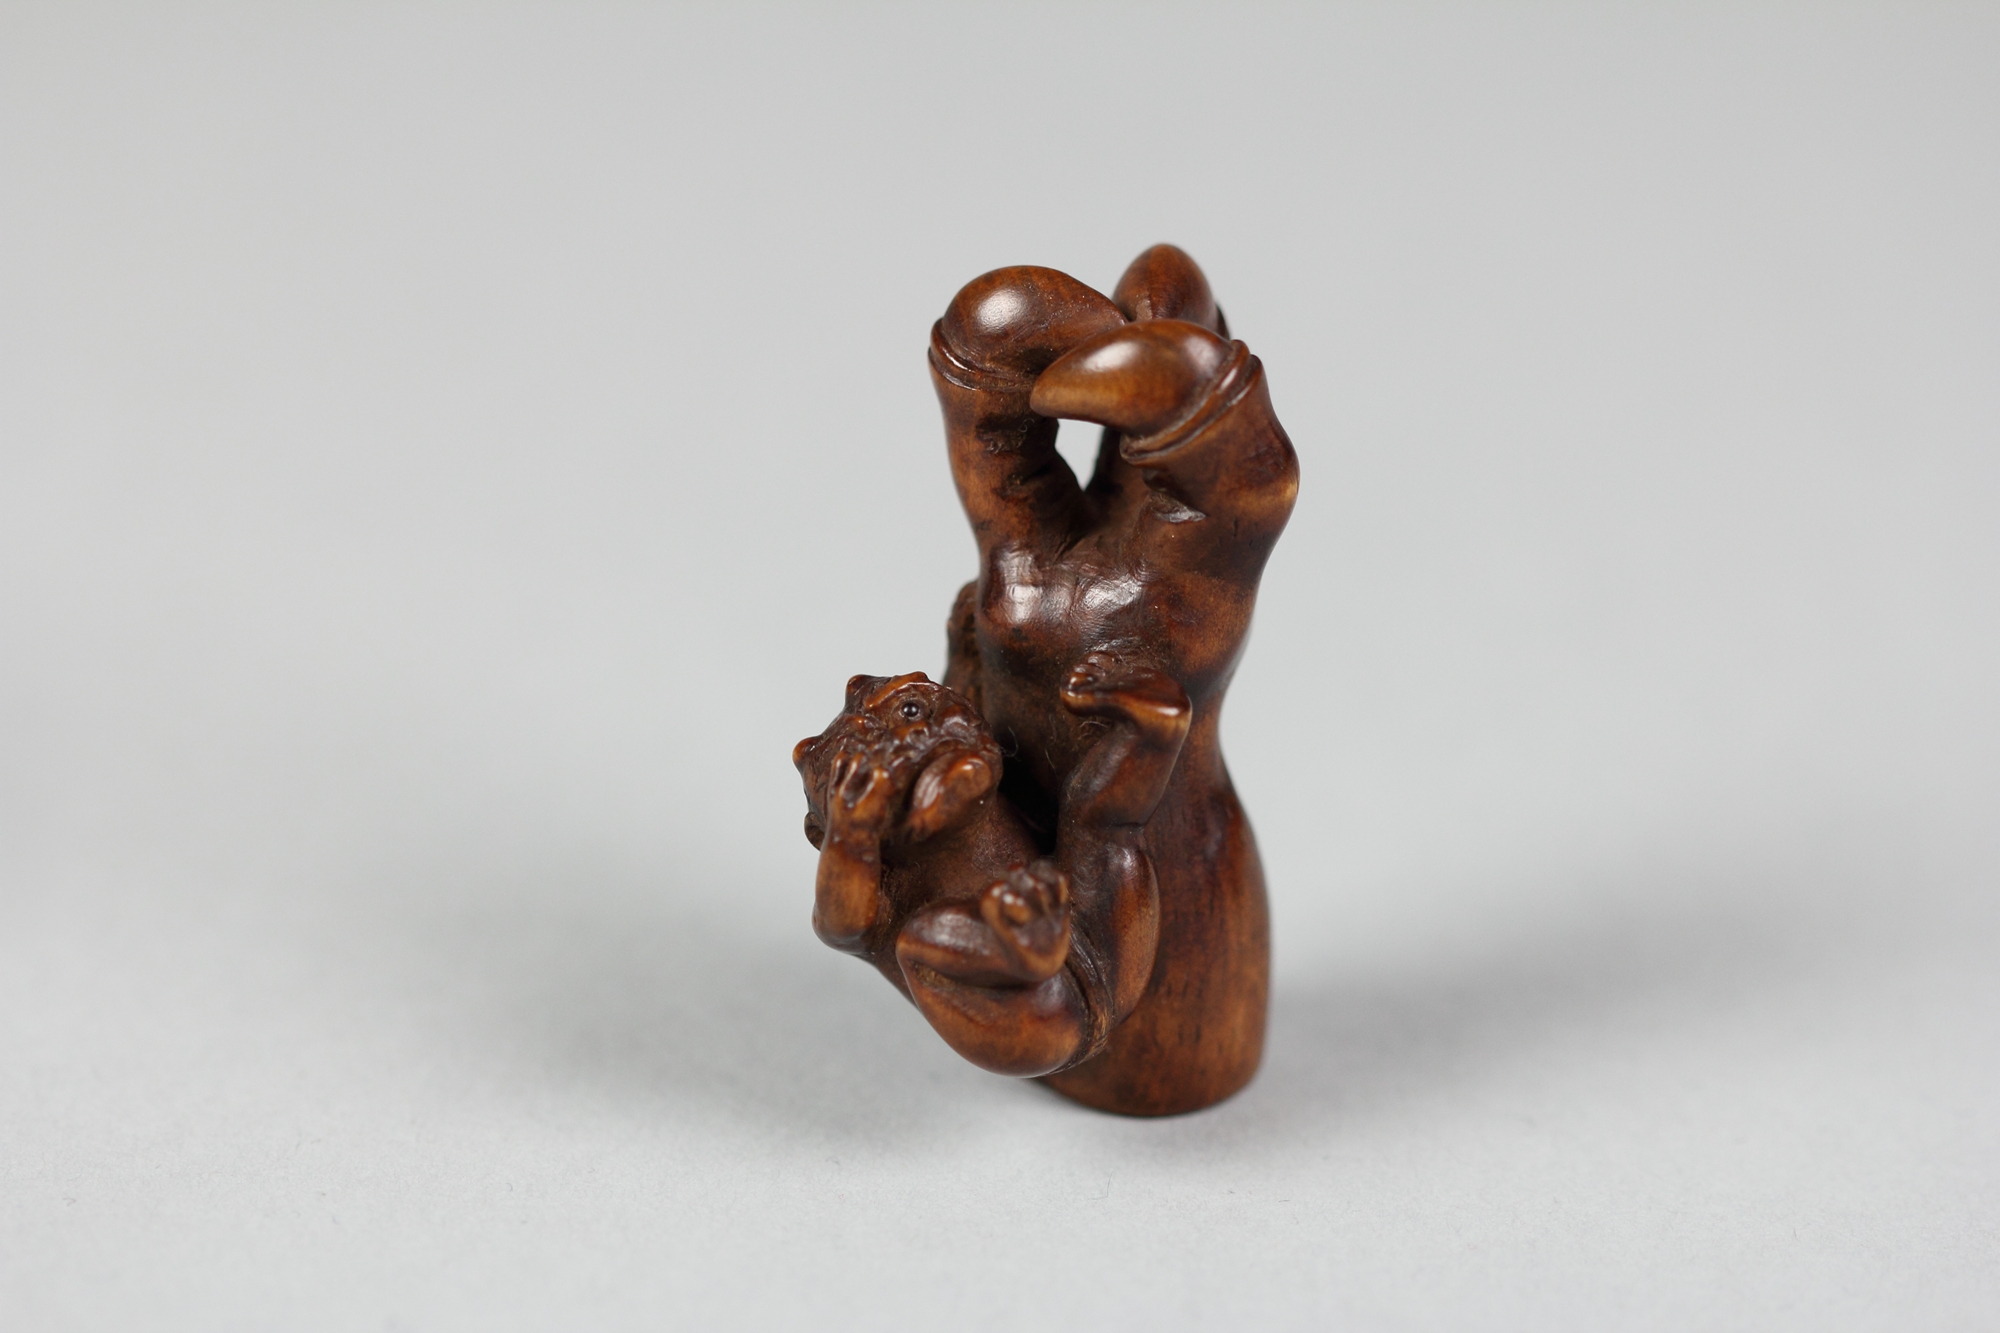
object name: netsuke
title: Netsuke of Ōni (Demon) Weeping Beside Giant Arm of Demon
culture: japanese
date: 1801-1900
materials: wood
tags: demons